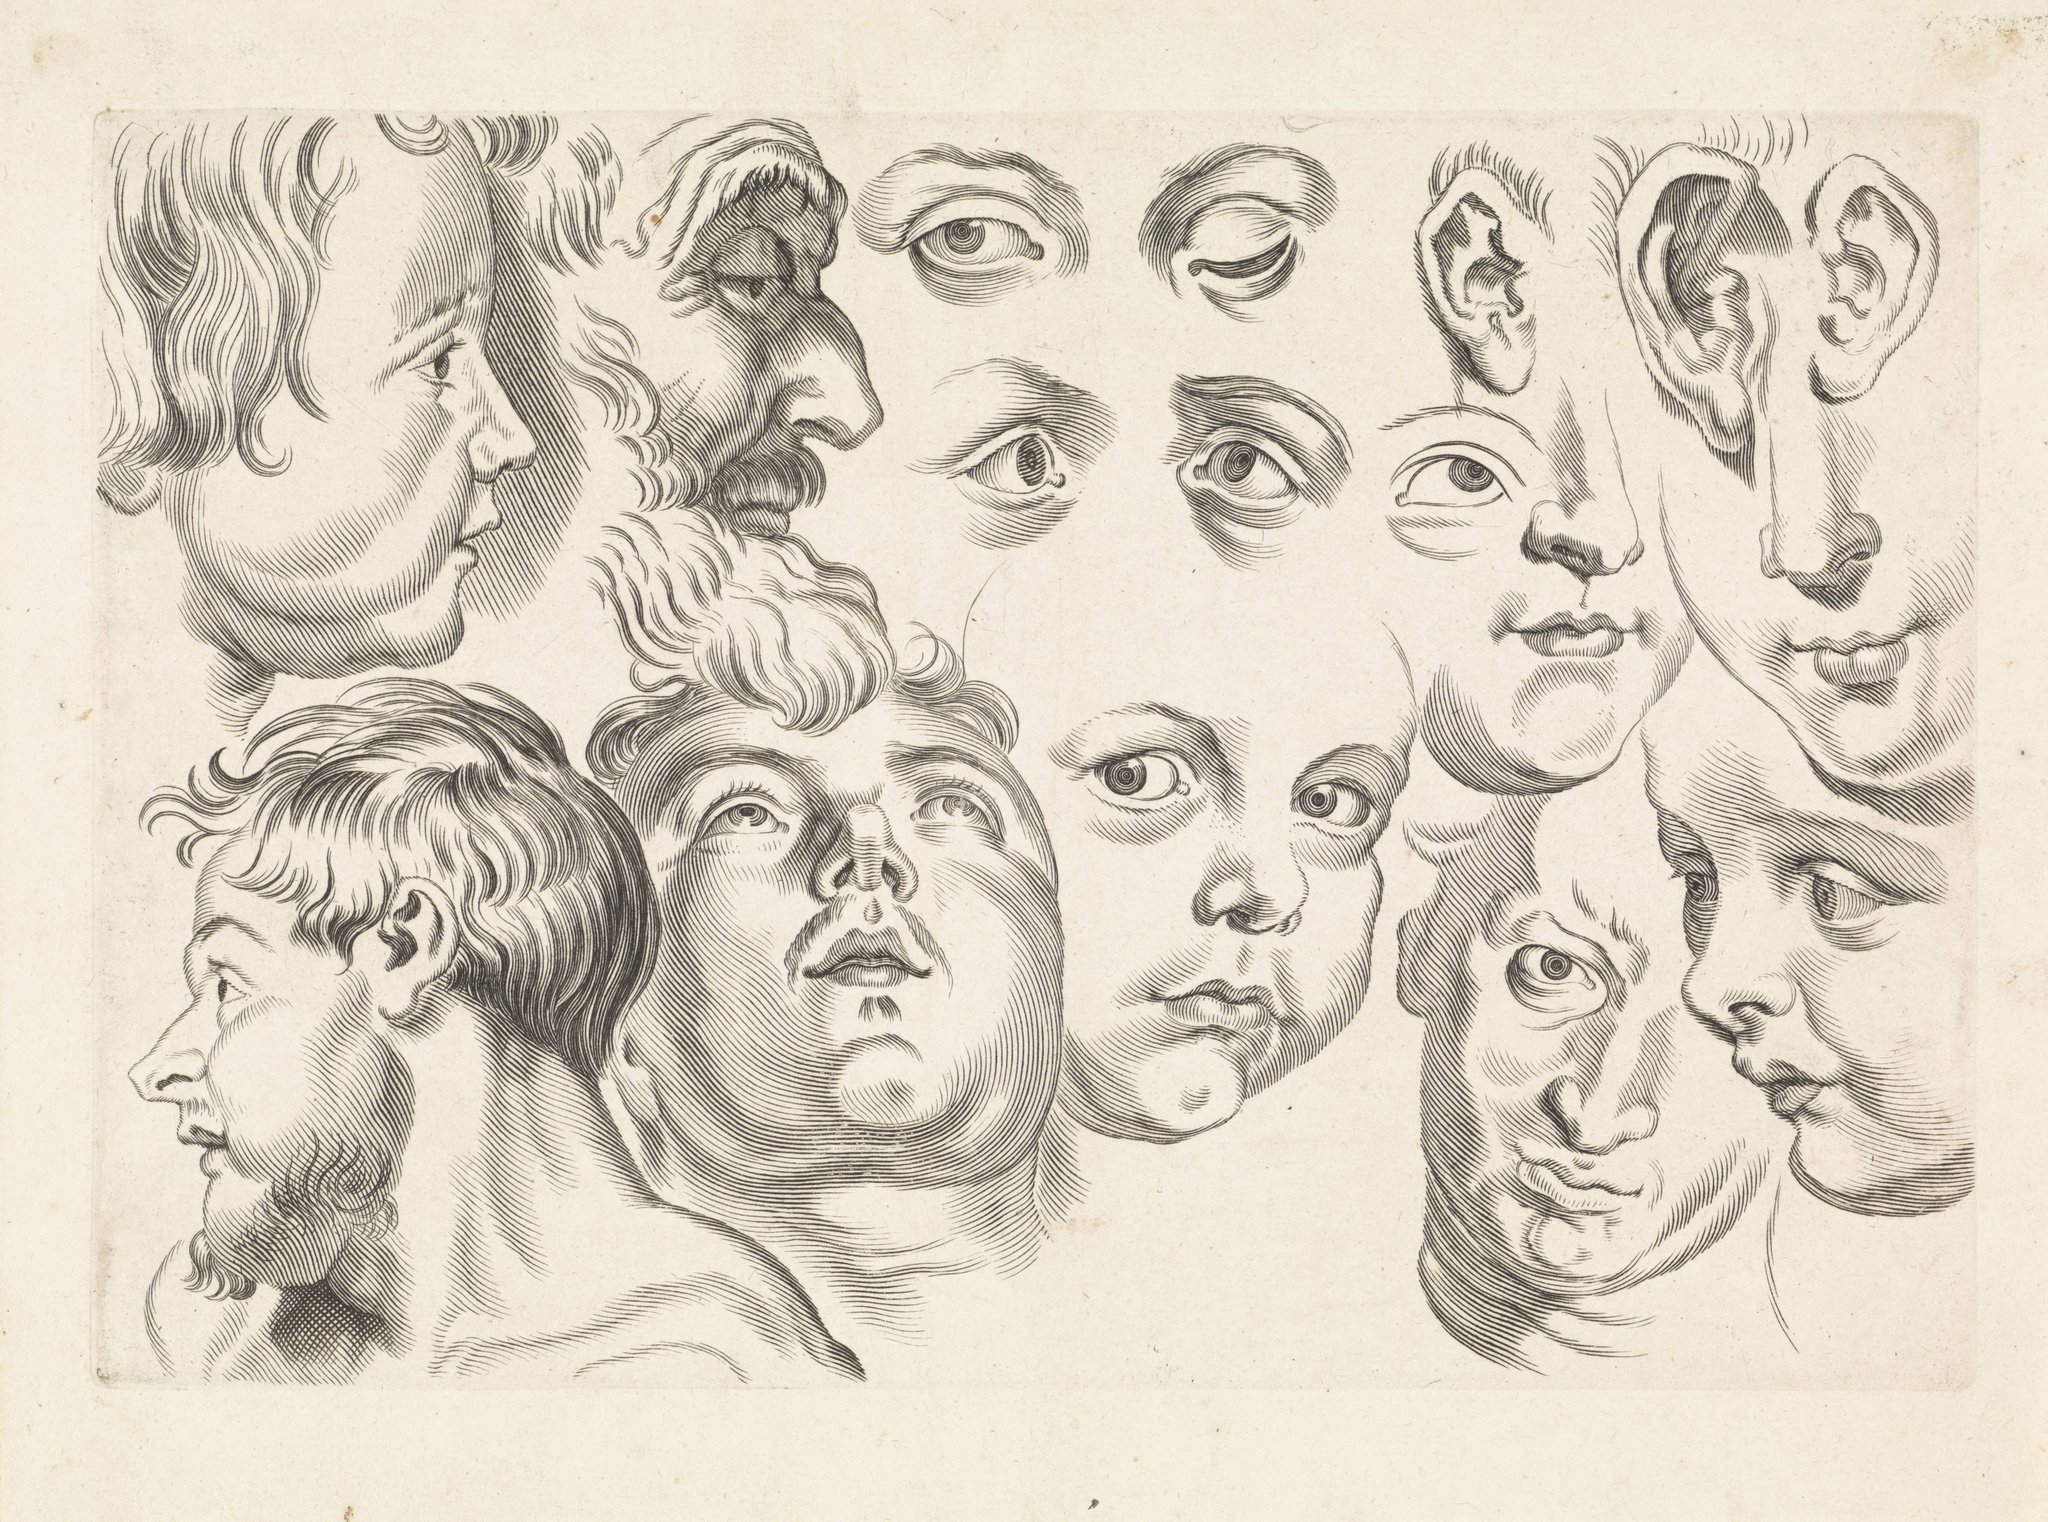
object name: print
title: Het tekenboek van Peter Paul Rubens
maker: paulus pontius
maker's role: draughtsman, print maker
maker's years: 1603-1658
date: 1616-1657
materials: paper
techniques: engraving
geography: antwerp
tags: human beings (legendary or not) of abnormal proportions, size, strength, etc. (+ head, face)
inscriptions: number: ‘3’, collector's mark: Lugt 240